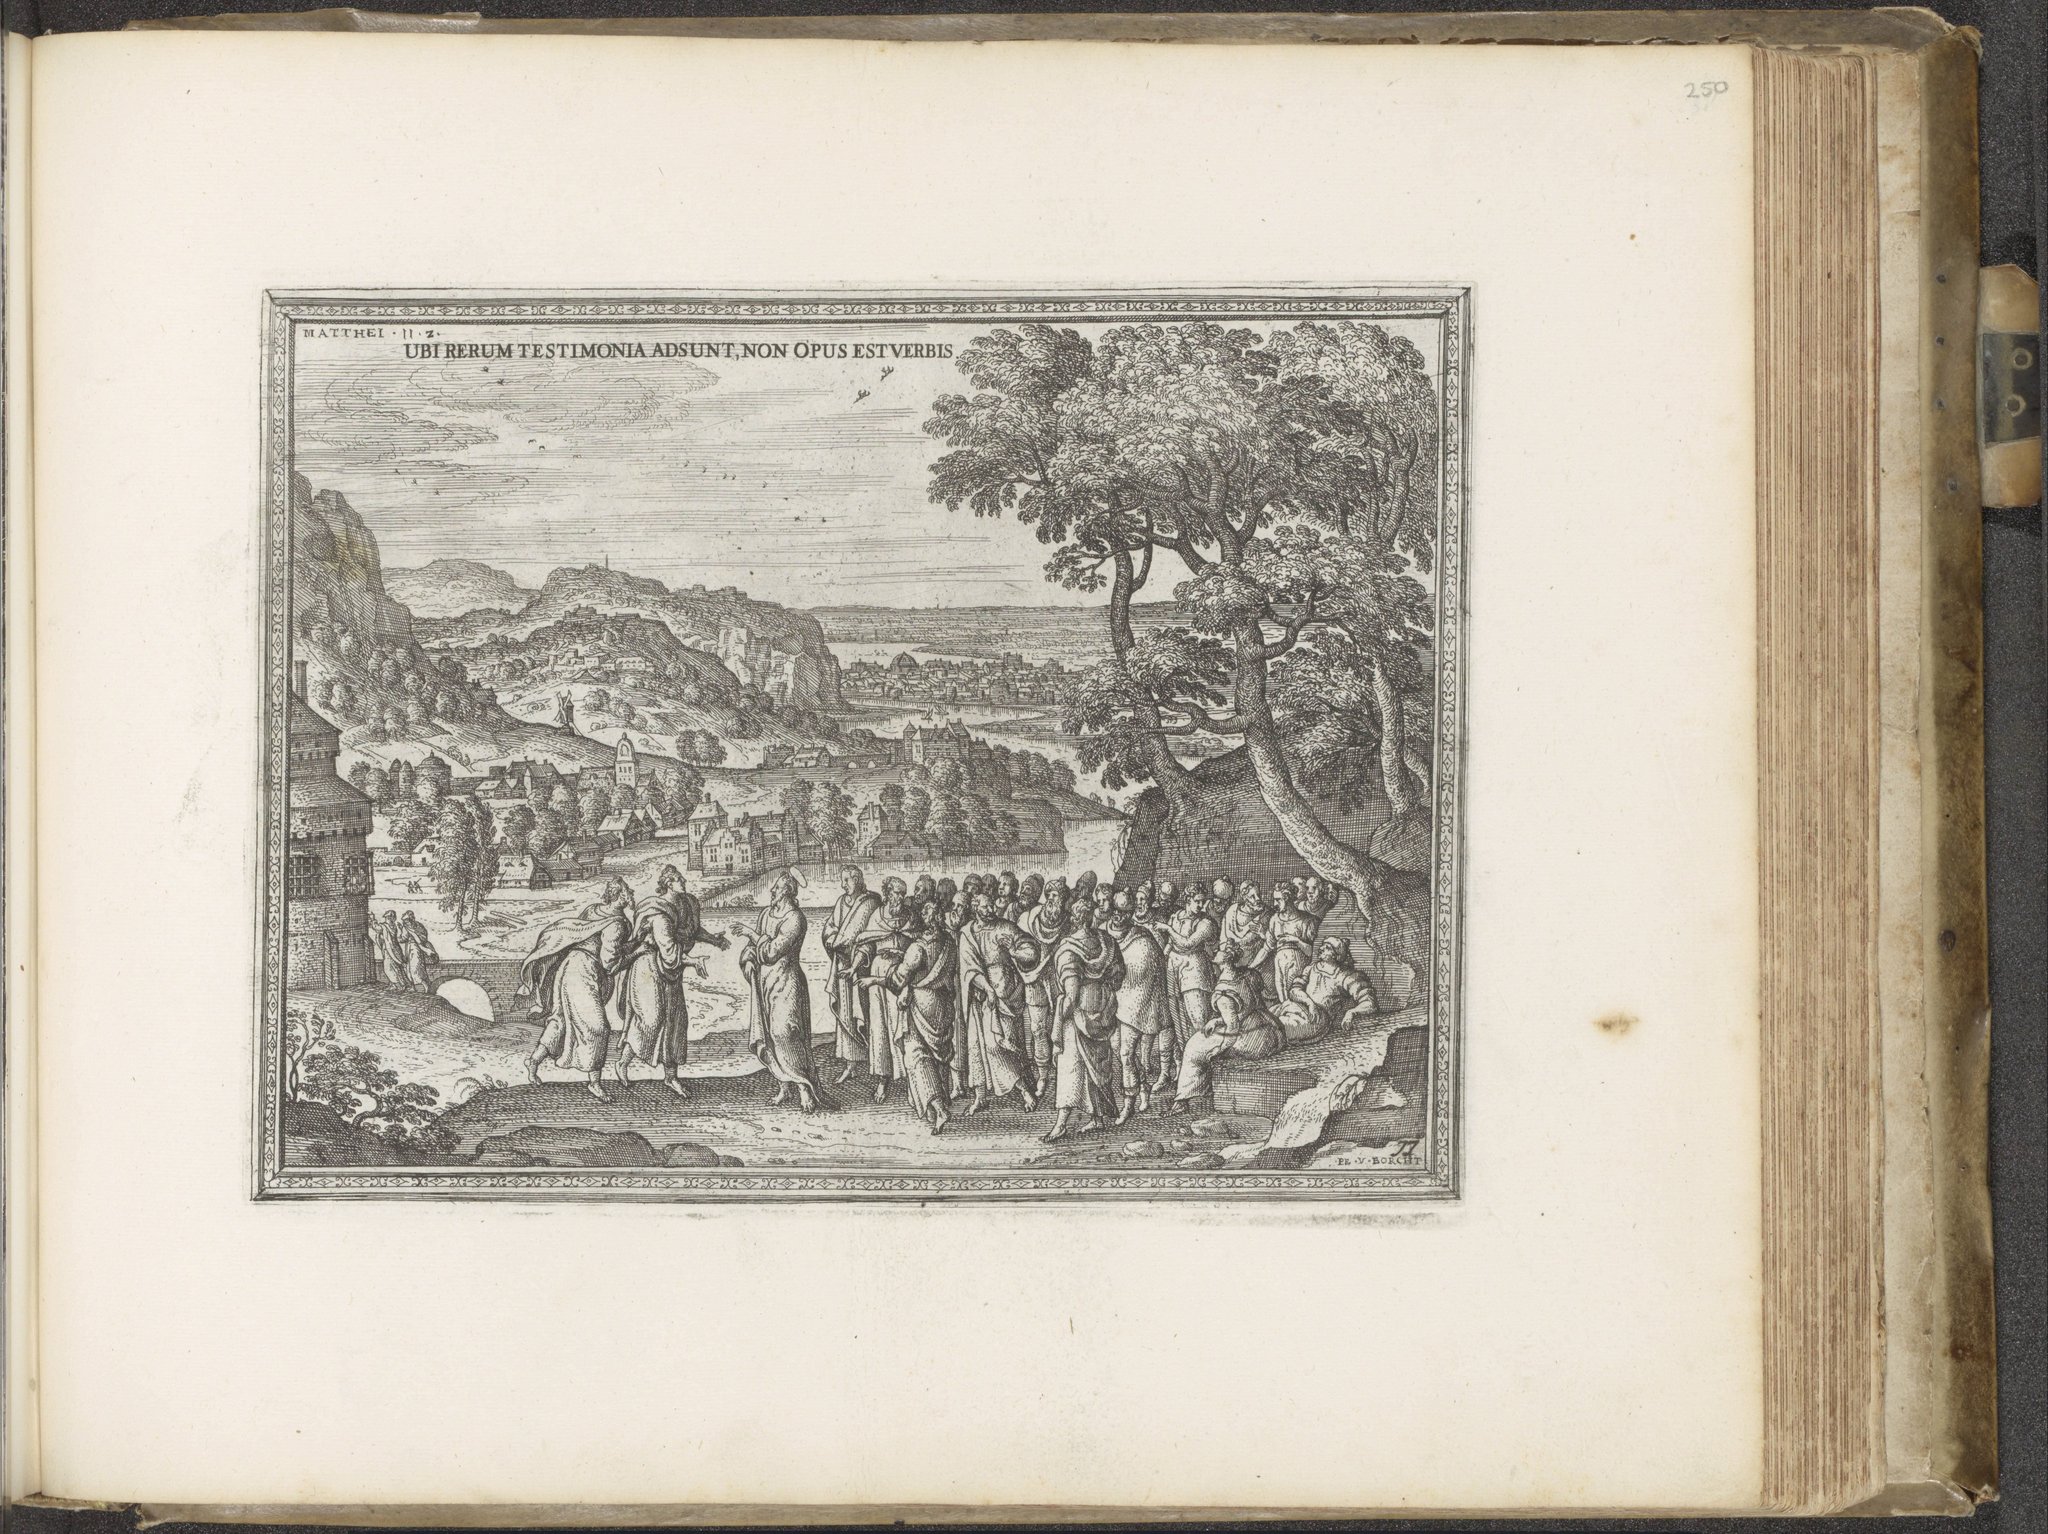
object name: print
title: Christus antwoordt de leerlingen van Johannes de Doper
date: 1582-1593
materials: paper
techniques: etching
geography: amsterdam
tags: dale, valley, city-view, and landscape with man-made constructions, landscapes with waters, waterscapes, seascapes (in the temperate zone), two disciples of john the baptist are sent to christ (matthew 11:2-6; luke 7:18-23)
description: Rivierlandschap. Links zit Johannes de Doper in de gevangenis. Johannes hoort daar over het optreden van Christus en stuurt twee van zijn leerlingen naar hem toe met de vraag of hij de messias is (Mat. 11:2). De prent maakt deel uit van een album.